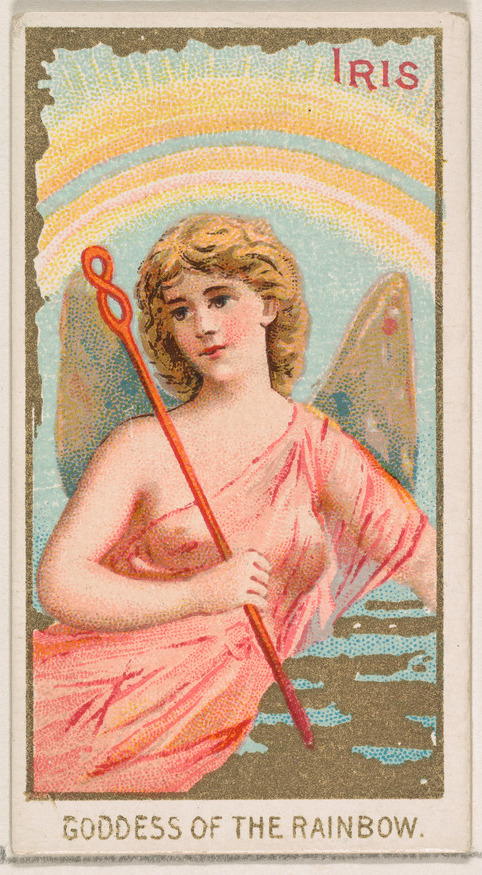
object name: print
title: Iris, Goddess of the Rainbow, from the Goddesses of the Greeks and Romans series (N188) issued by Wm. S. Kimball & Co.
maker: william s. kimball & company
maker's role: publisher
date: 1889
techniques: color lithograph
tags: goddess